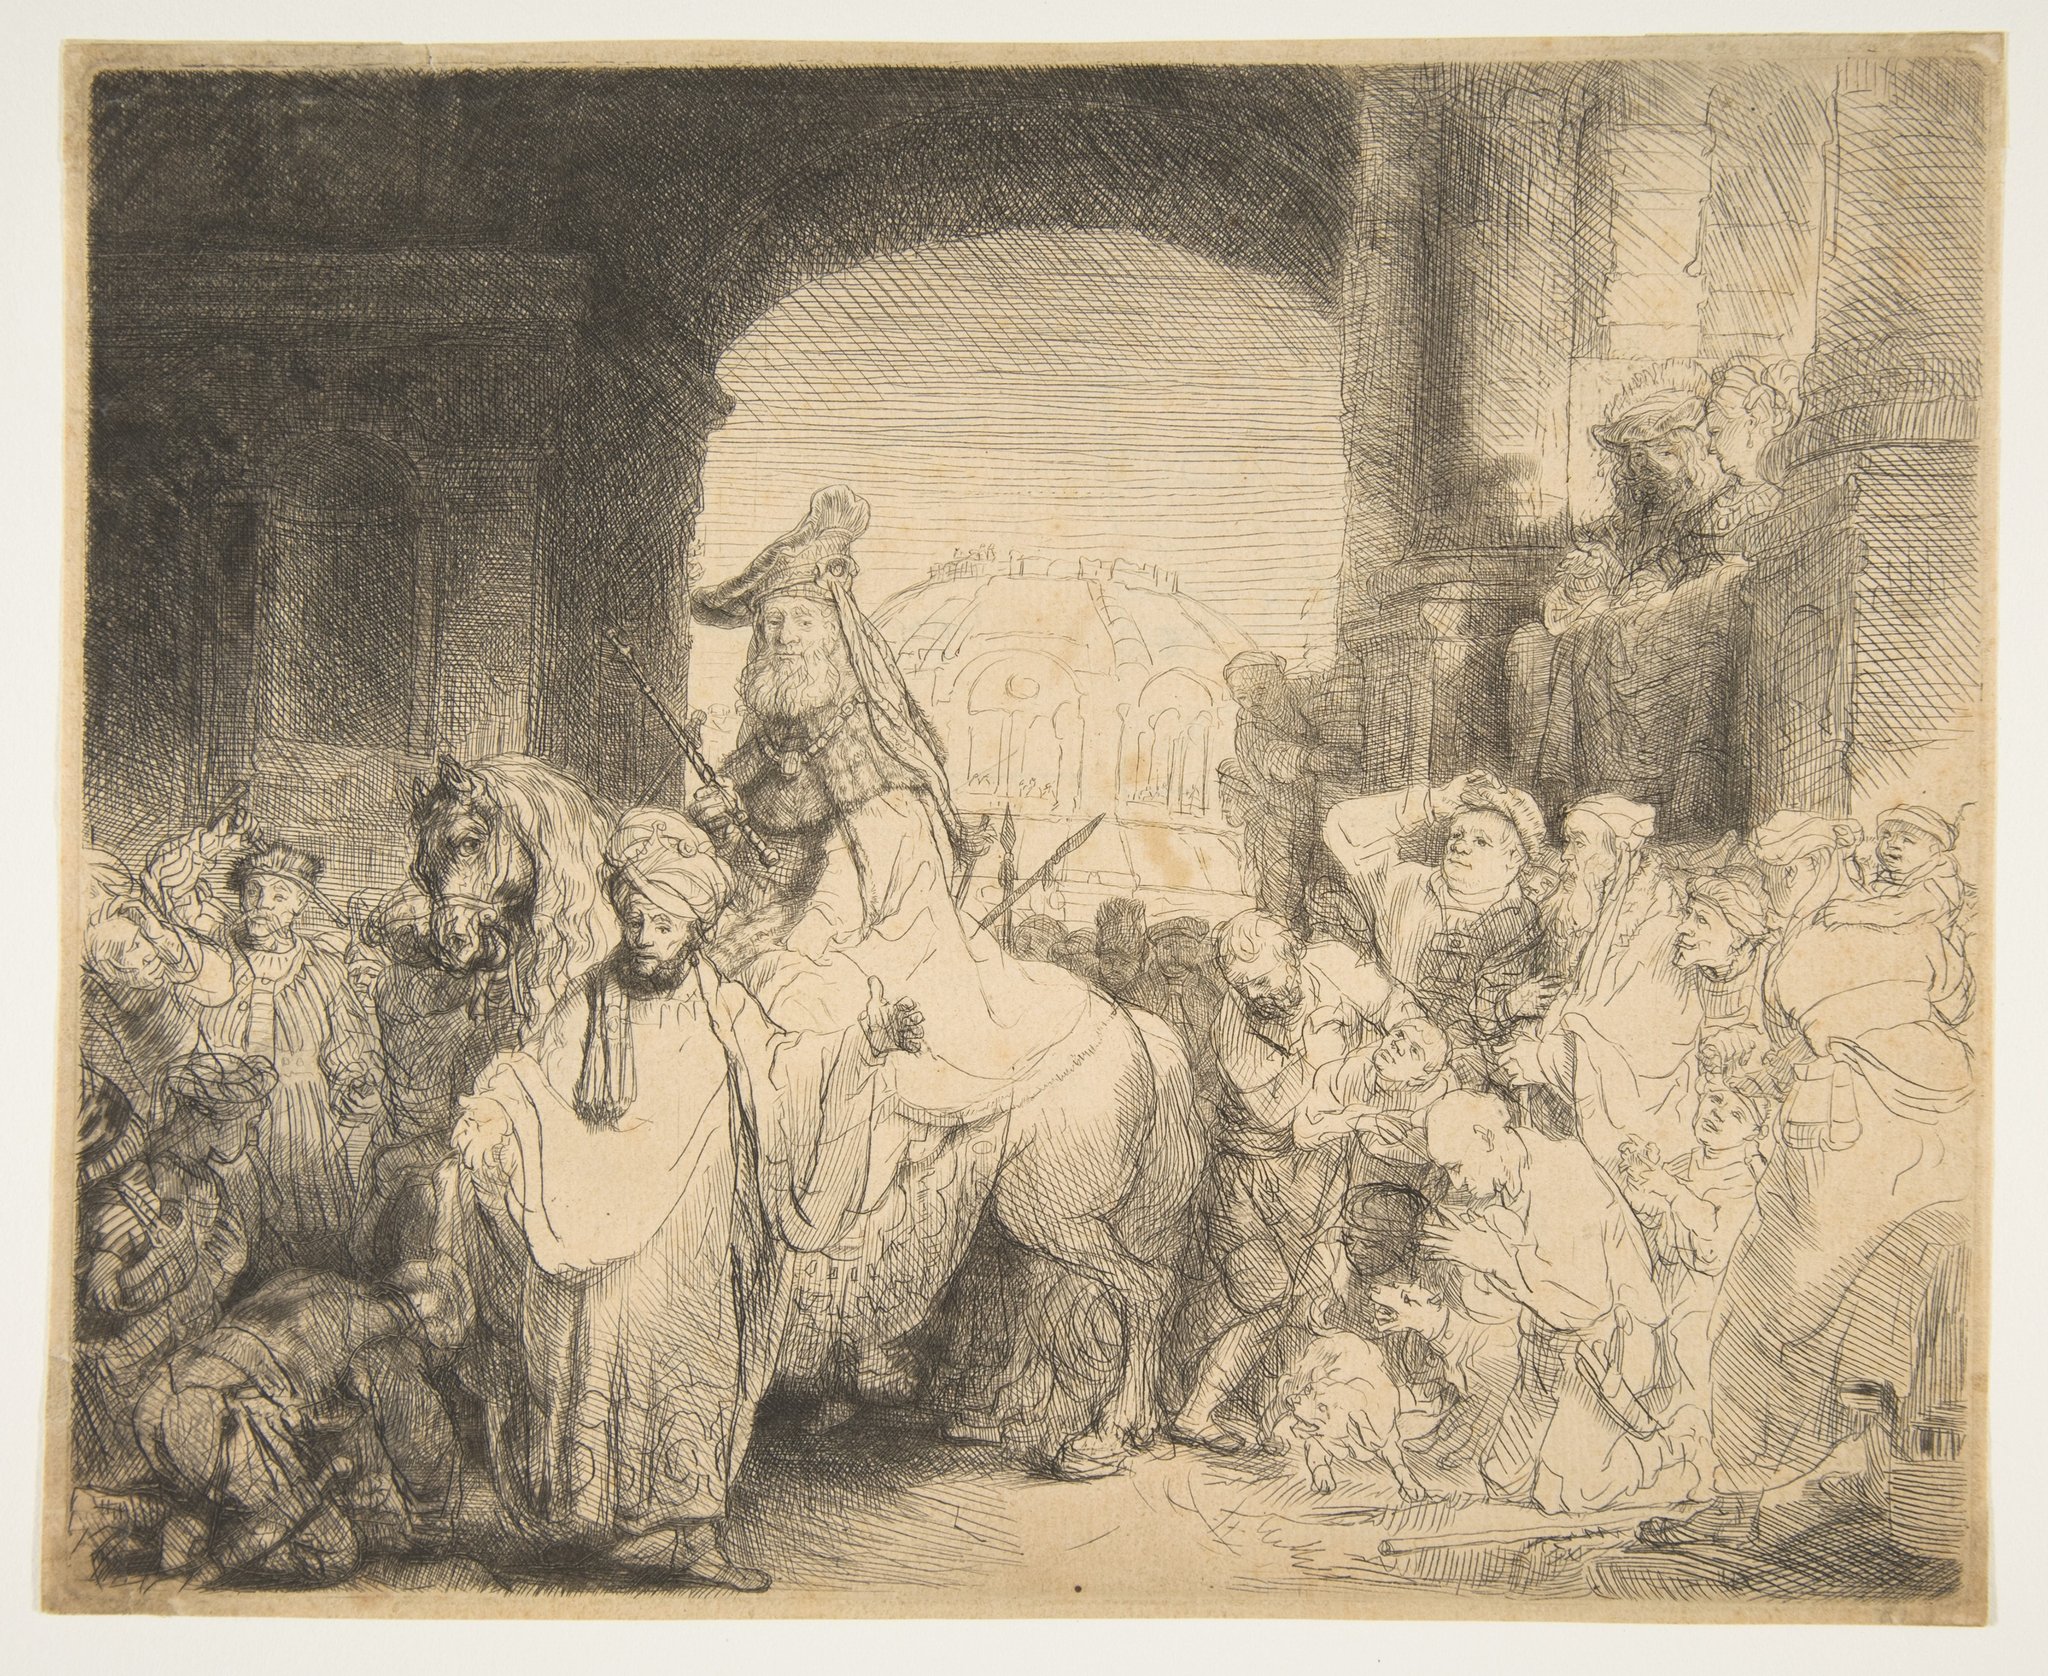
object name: print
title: The Triumph of Mordecai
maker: rembrandt van rijn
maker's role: artist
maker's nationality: dutch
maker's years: 1606-1669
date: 1641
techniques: drypoint, etching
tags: men,horses,crowd